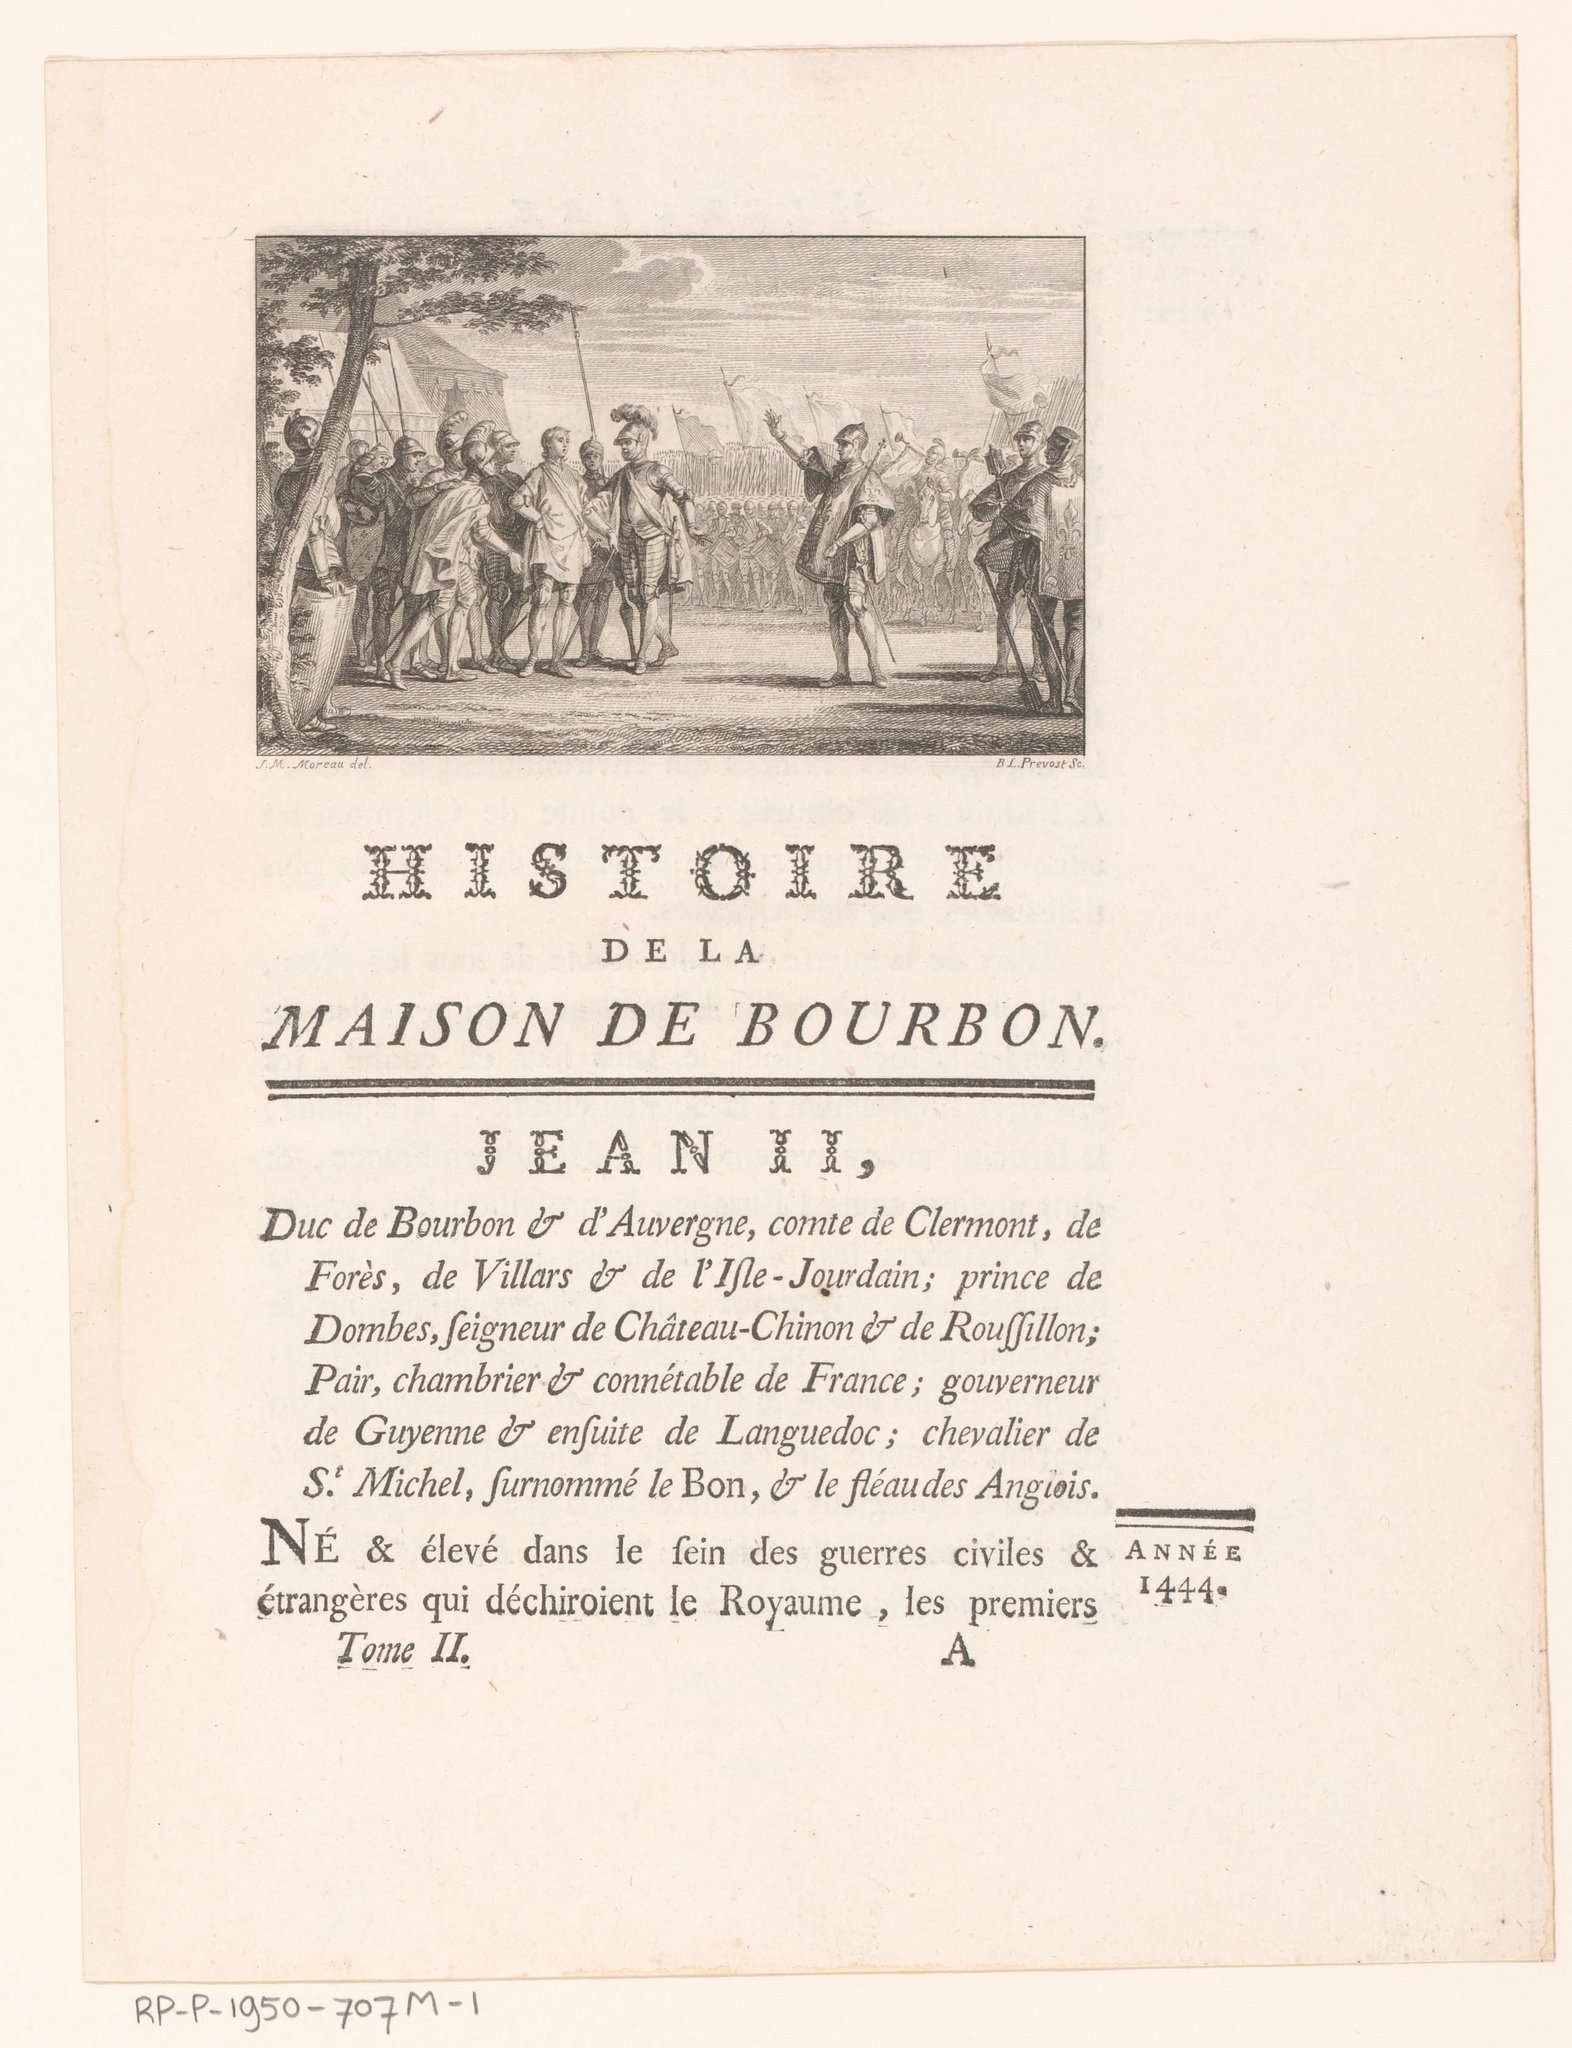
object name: print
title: Jan II van Bourbon tijdens de belegering van Metz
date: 1776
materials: paper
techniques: engraving, etching, letterpress printing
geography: paris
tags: ranks in the army, nobility and patriciate; chivalry, knighthood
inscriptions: collector's mark: Lugt 2228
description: Prent uit: Désormeaux, Joseph-Louis-Ripault. Histoire de la maison de Bourbon. Parijs: L'Imprimerie Royale, 1776, dl. 2, p. 1.